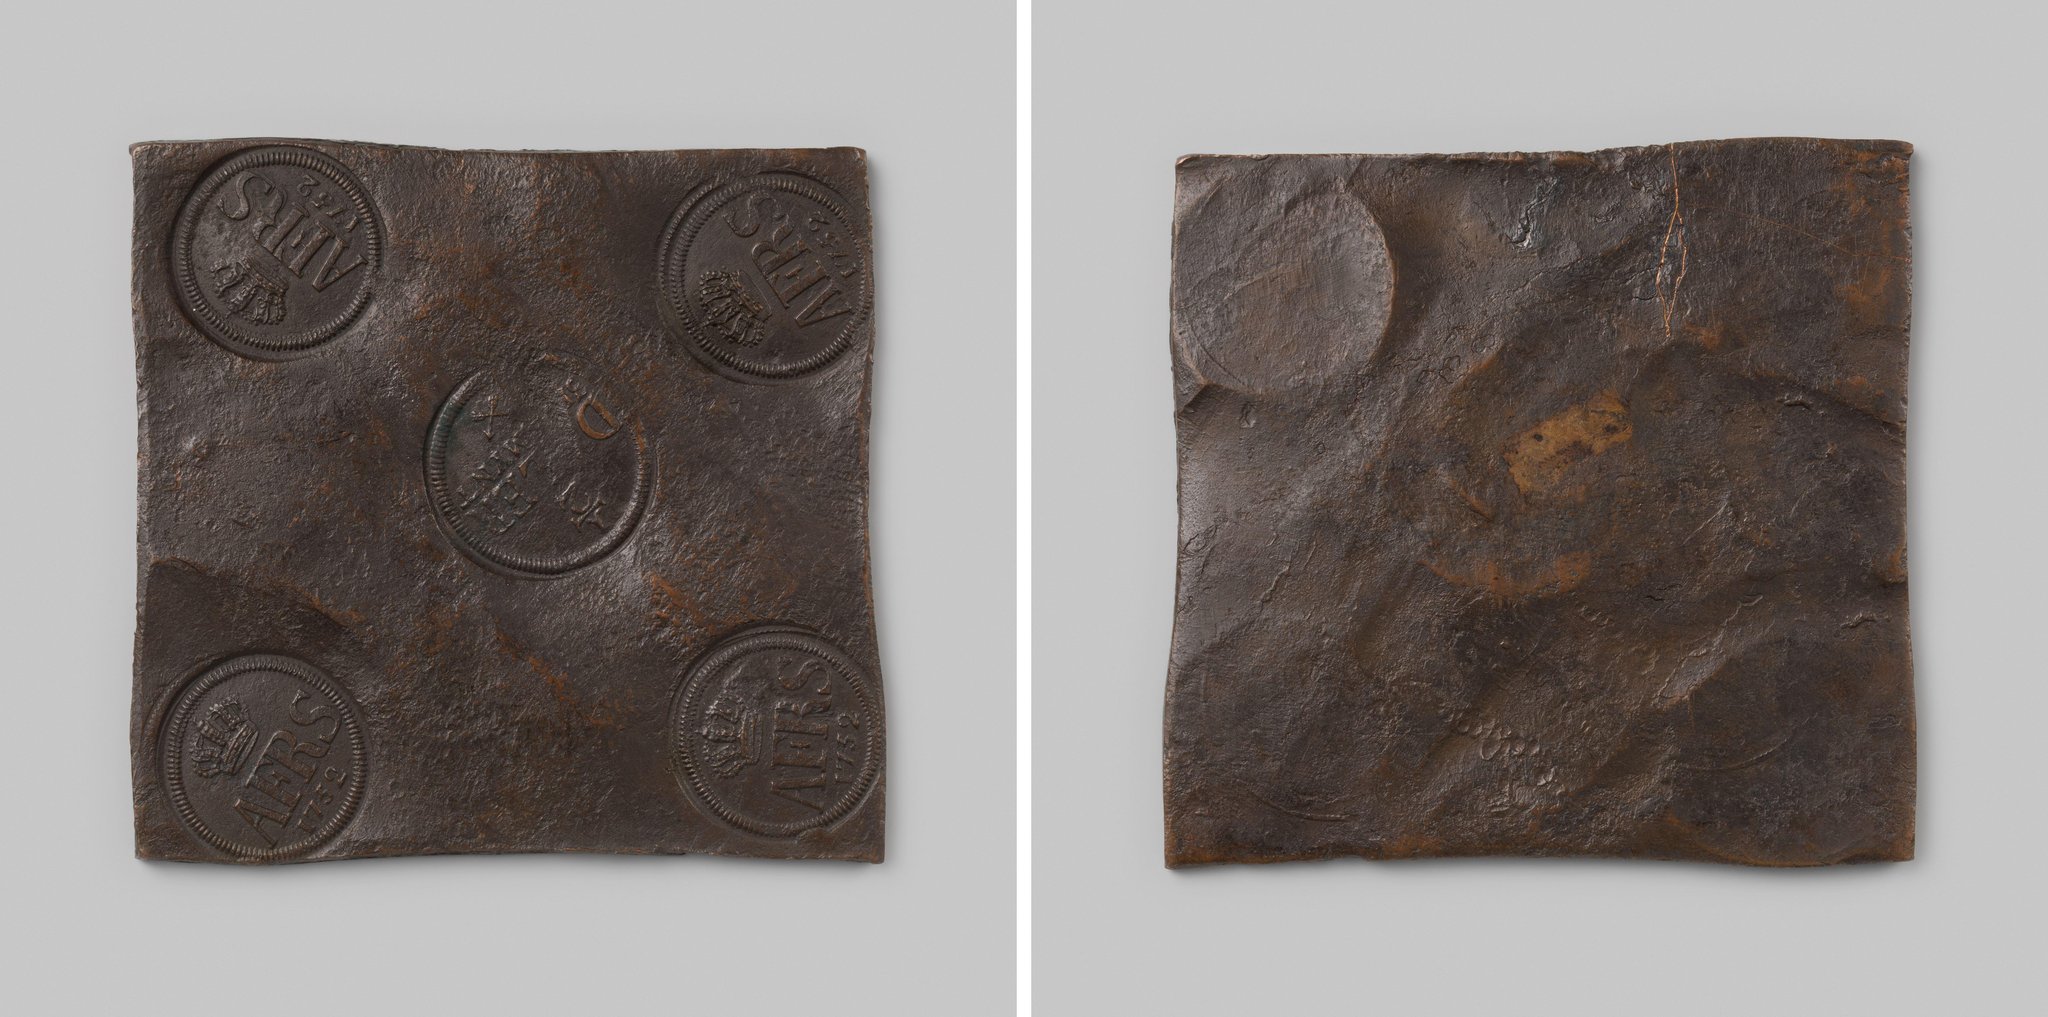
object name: plaatgeld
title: Plaatgeld van een halve daler op naam van Adolf Frederik, koning van Zweden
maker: Anonymous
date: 1752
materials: copper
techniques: striking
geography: karlberg palace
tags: gottorp, stockholm, koning, adolf frederik (koning van zweden), zweden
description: Eenzijdige, vrijwel rechthoekige plaat met daarin geslagen vijf stempelafdruk. Voorzijde: in elke hoek afdruk van de voorzijde van halve daler: monogram en jaartal onder kroon; in midden afdruk van keerzijde van halve daler: opschrift. Keerzijde: blanco.